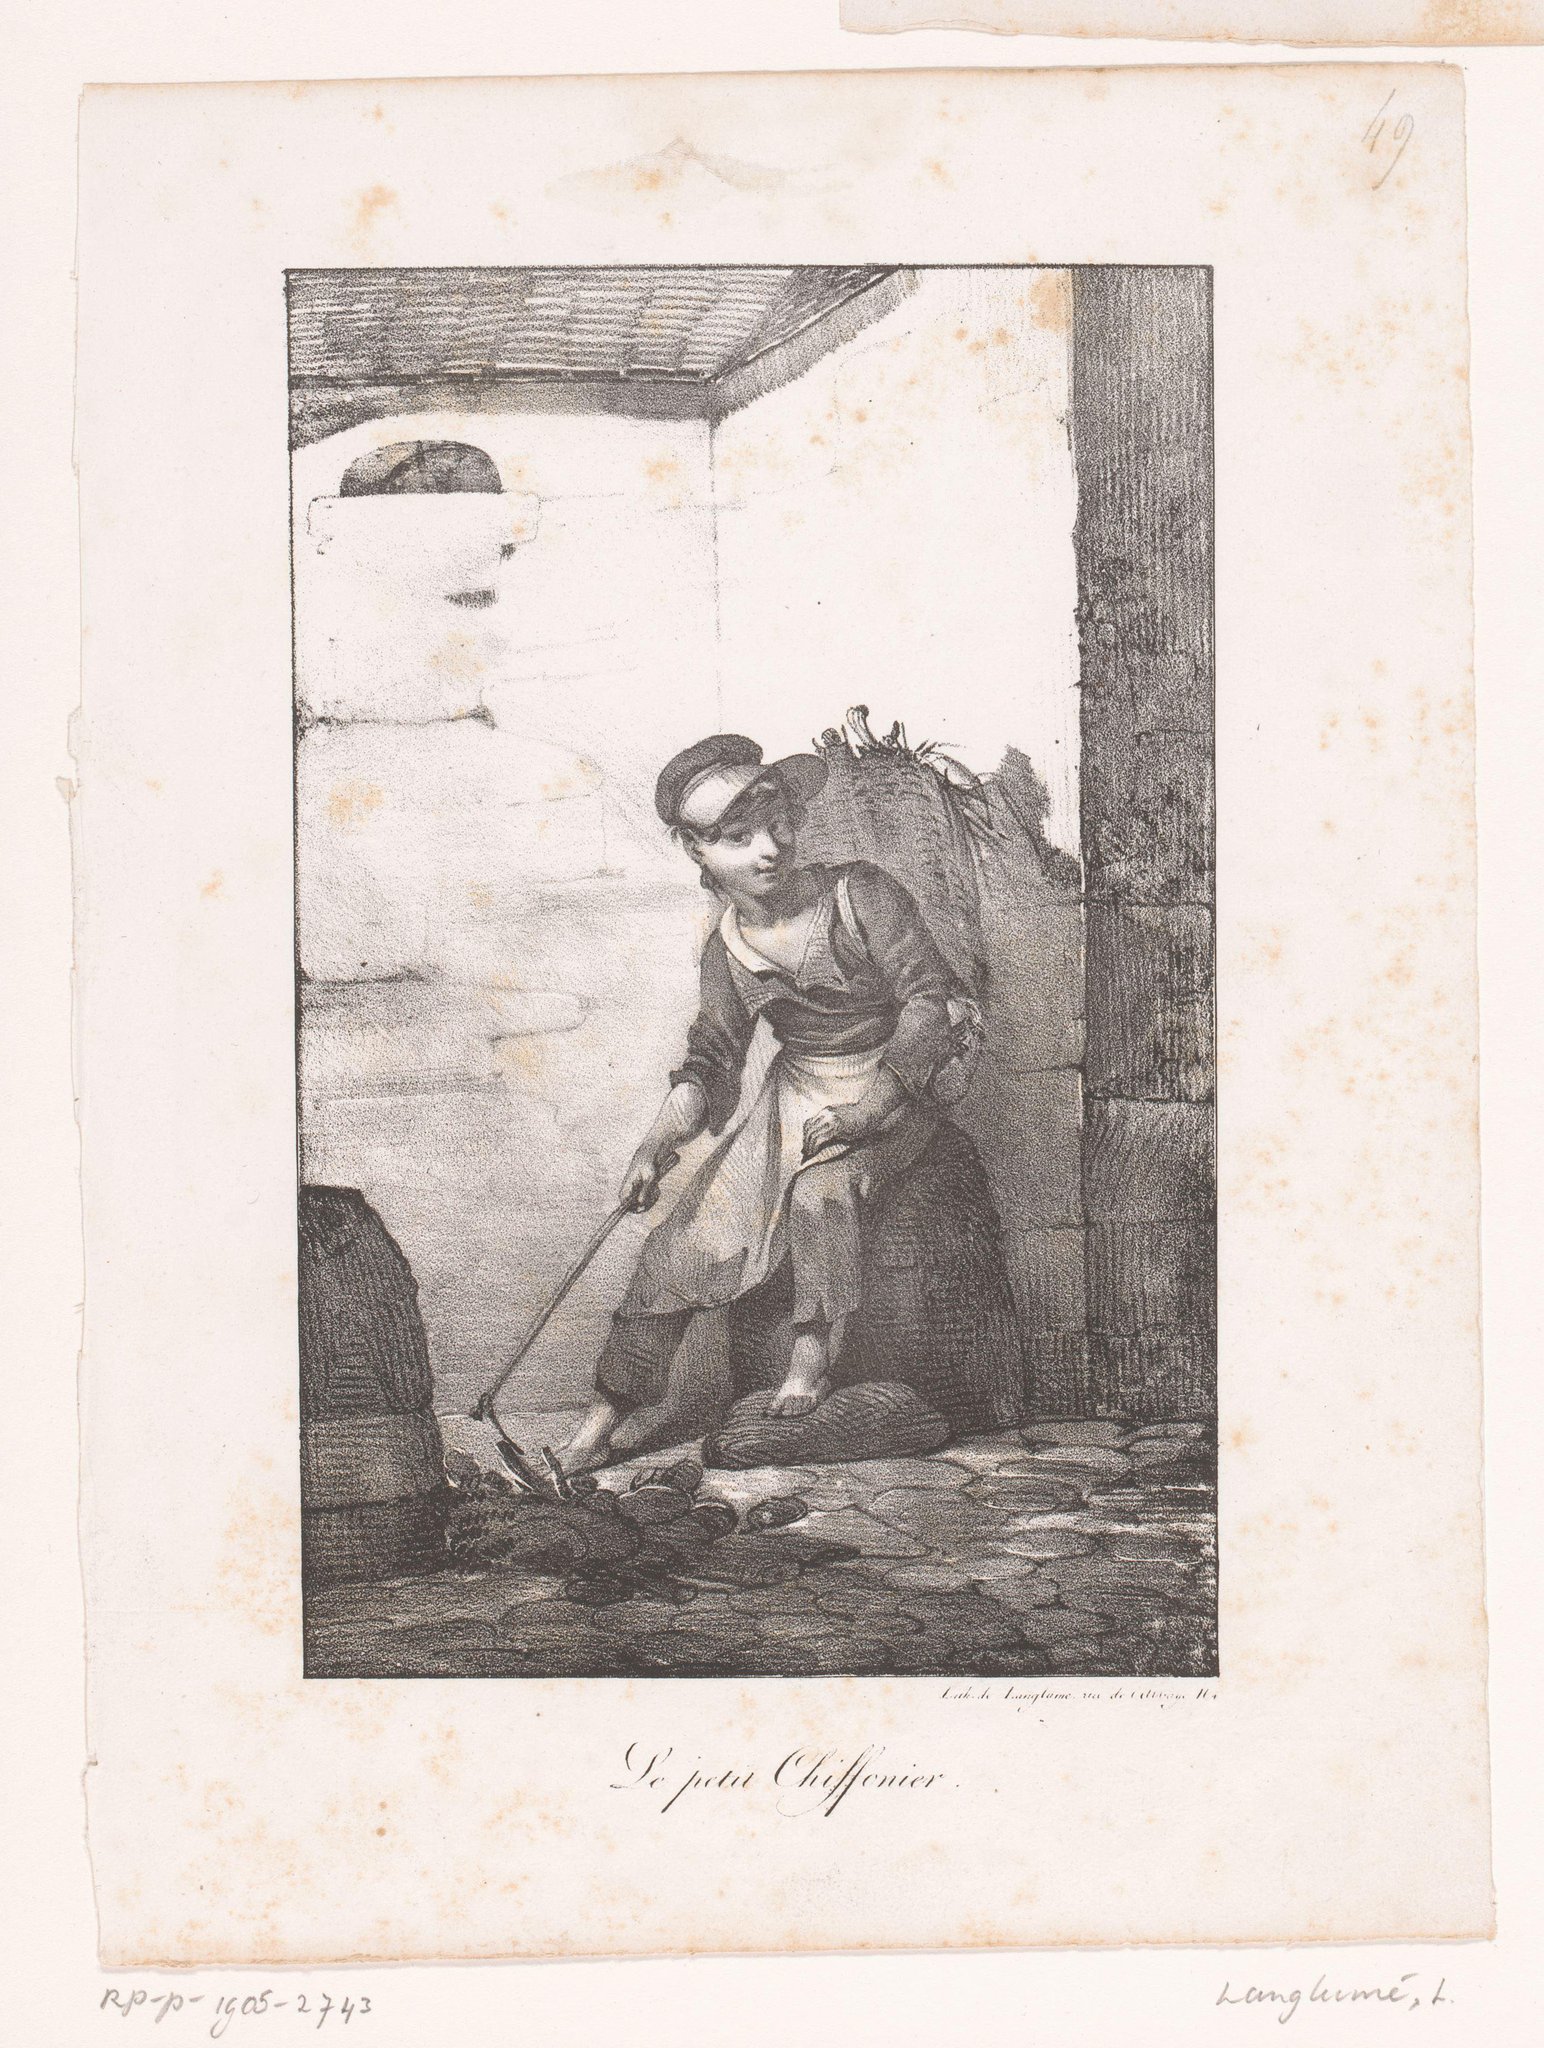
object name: print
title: Le petit Chiffonier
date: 1820-1830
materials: paper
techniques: lithograph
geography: paris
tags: boy (child between toddler and youth), clothed in rags, the poor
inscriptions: collector's mark: Lugt 2228a